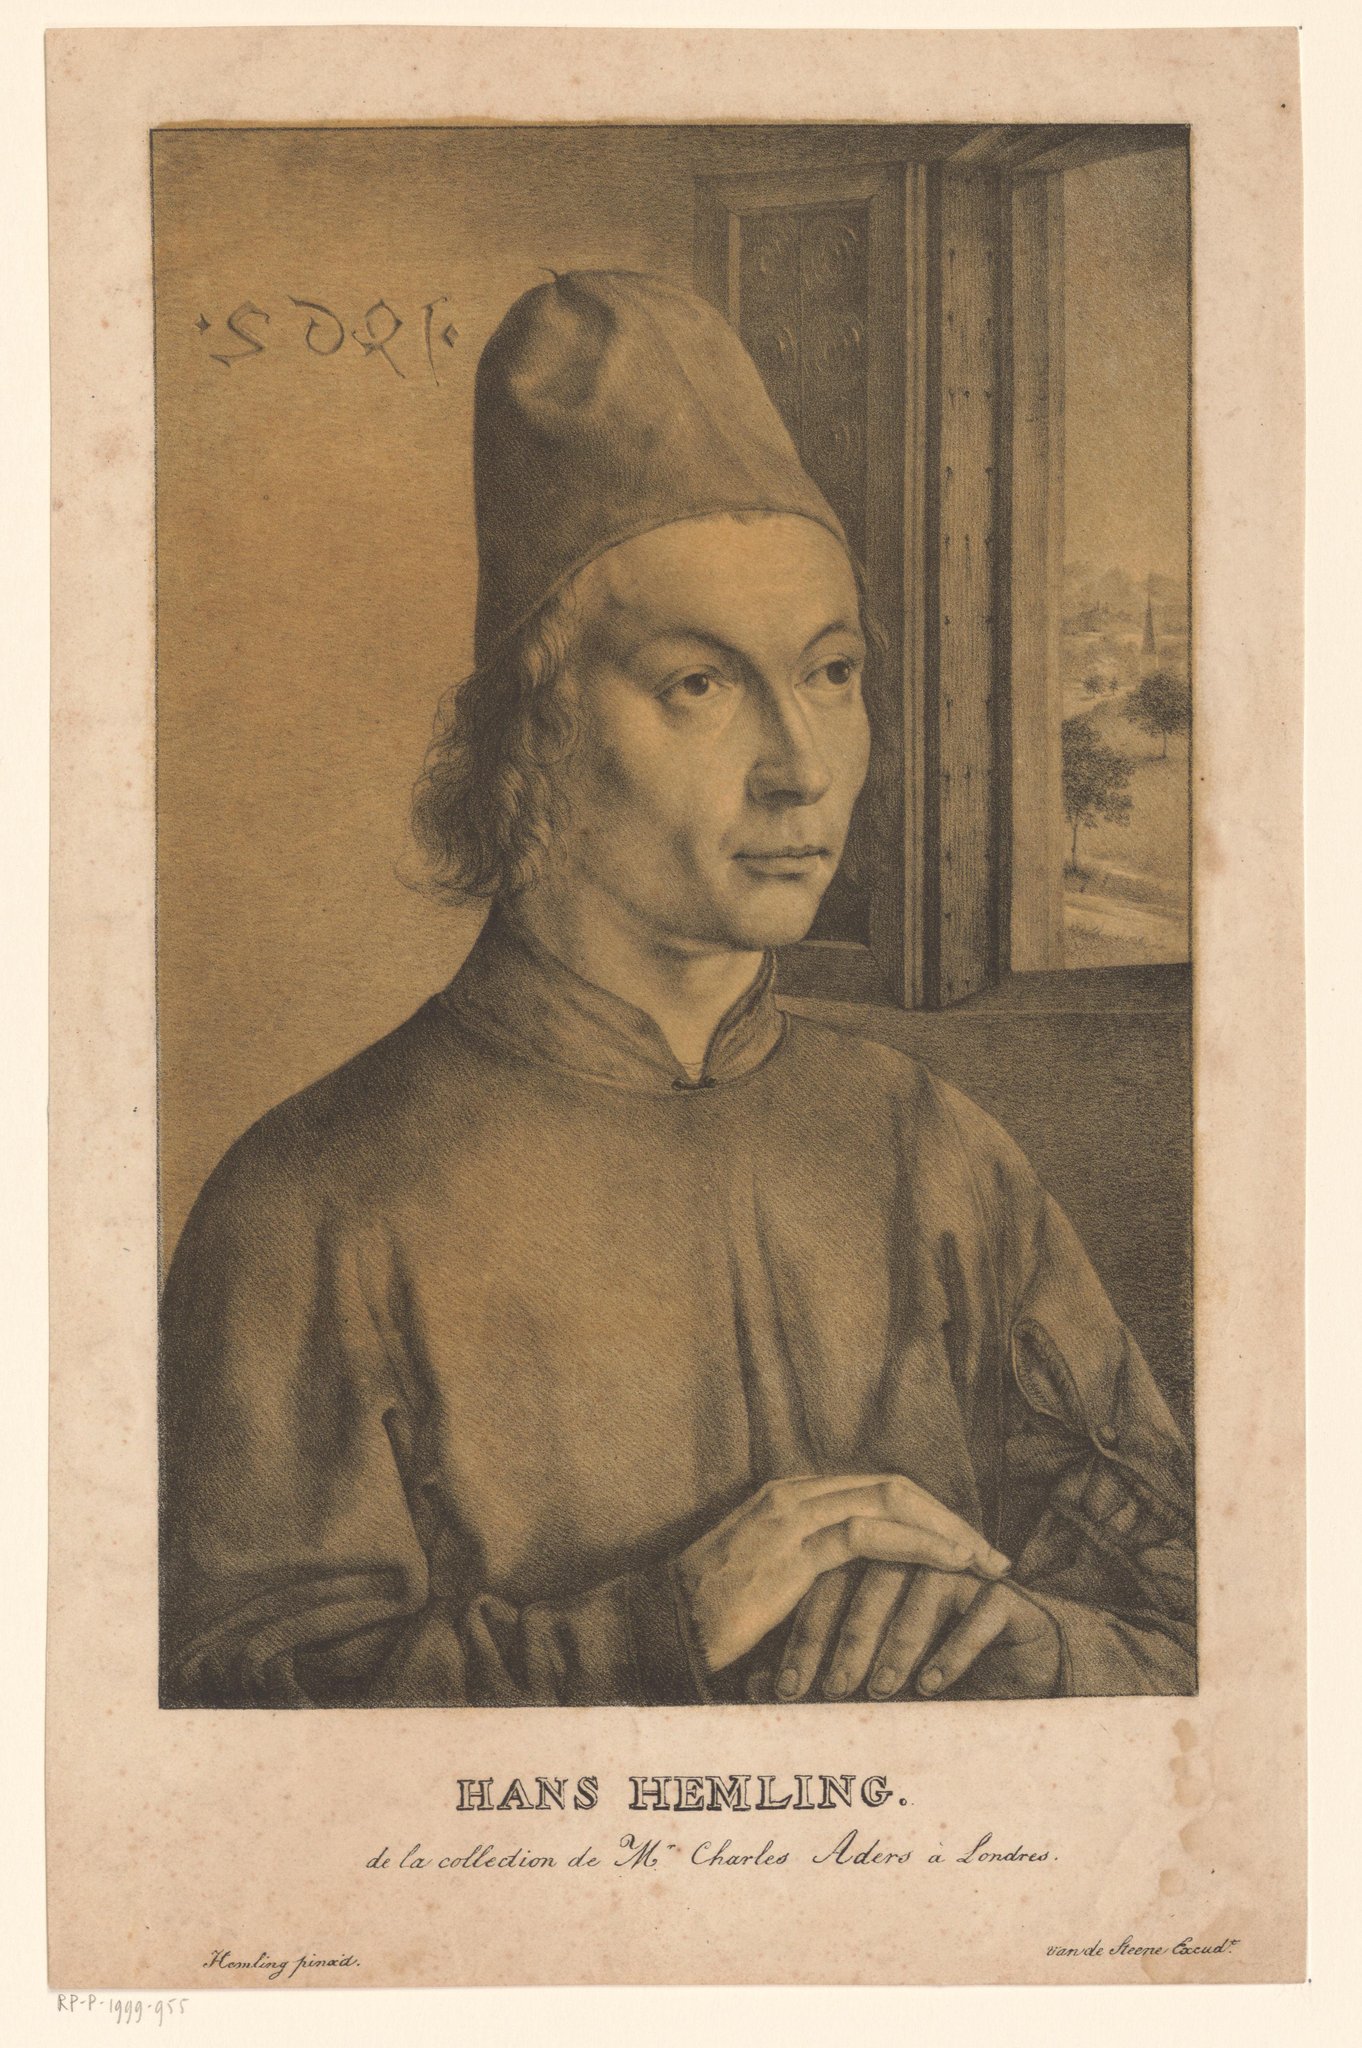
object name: print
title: Hans Hemling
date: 1821-1826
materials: paper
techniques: tone lithography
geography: bruges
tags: bruges, painter, draughtsman, hans memling, historical persons, portrait, self-portrait of painter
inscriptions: collector's mark: Lugt 2760, collector's mark: Lugt 2228